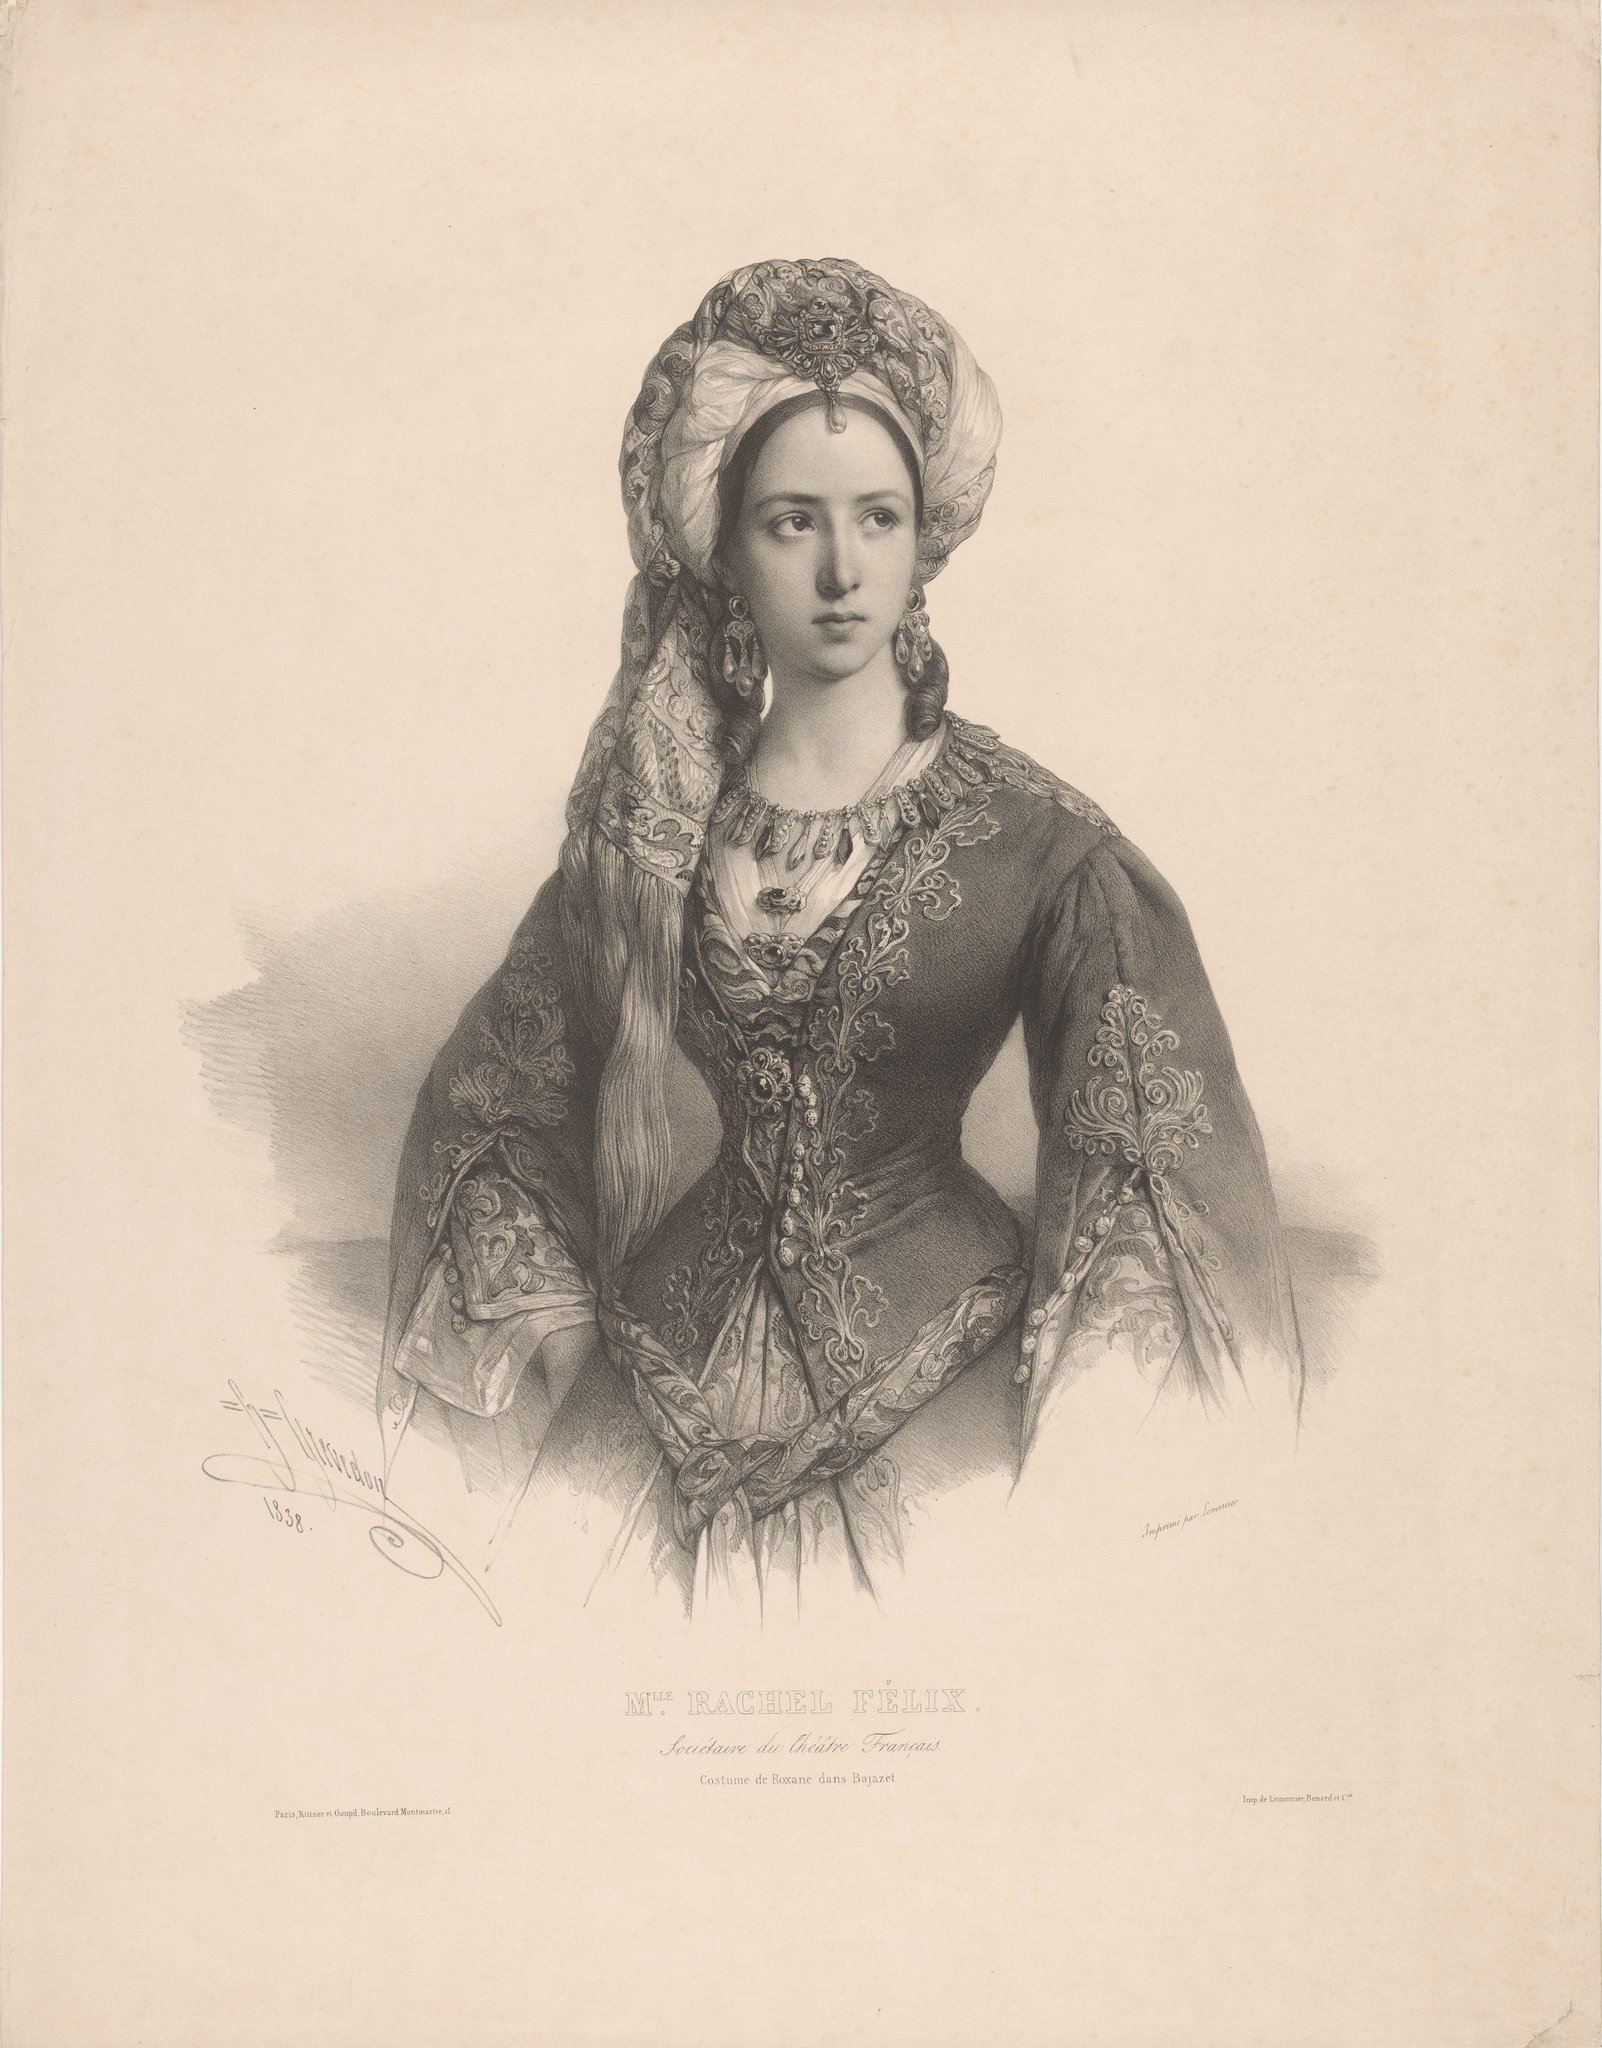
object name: print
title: Portret van Rachel Félix als Roxane in de tragedie Bajazet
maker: henri grévedon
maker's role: painter, print maker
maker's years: 1776-1860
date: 1838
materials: paper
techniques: lithograph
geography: paris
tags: historical persons, portrait of actor, actress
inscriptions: collector's mark: Lugt 2228a